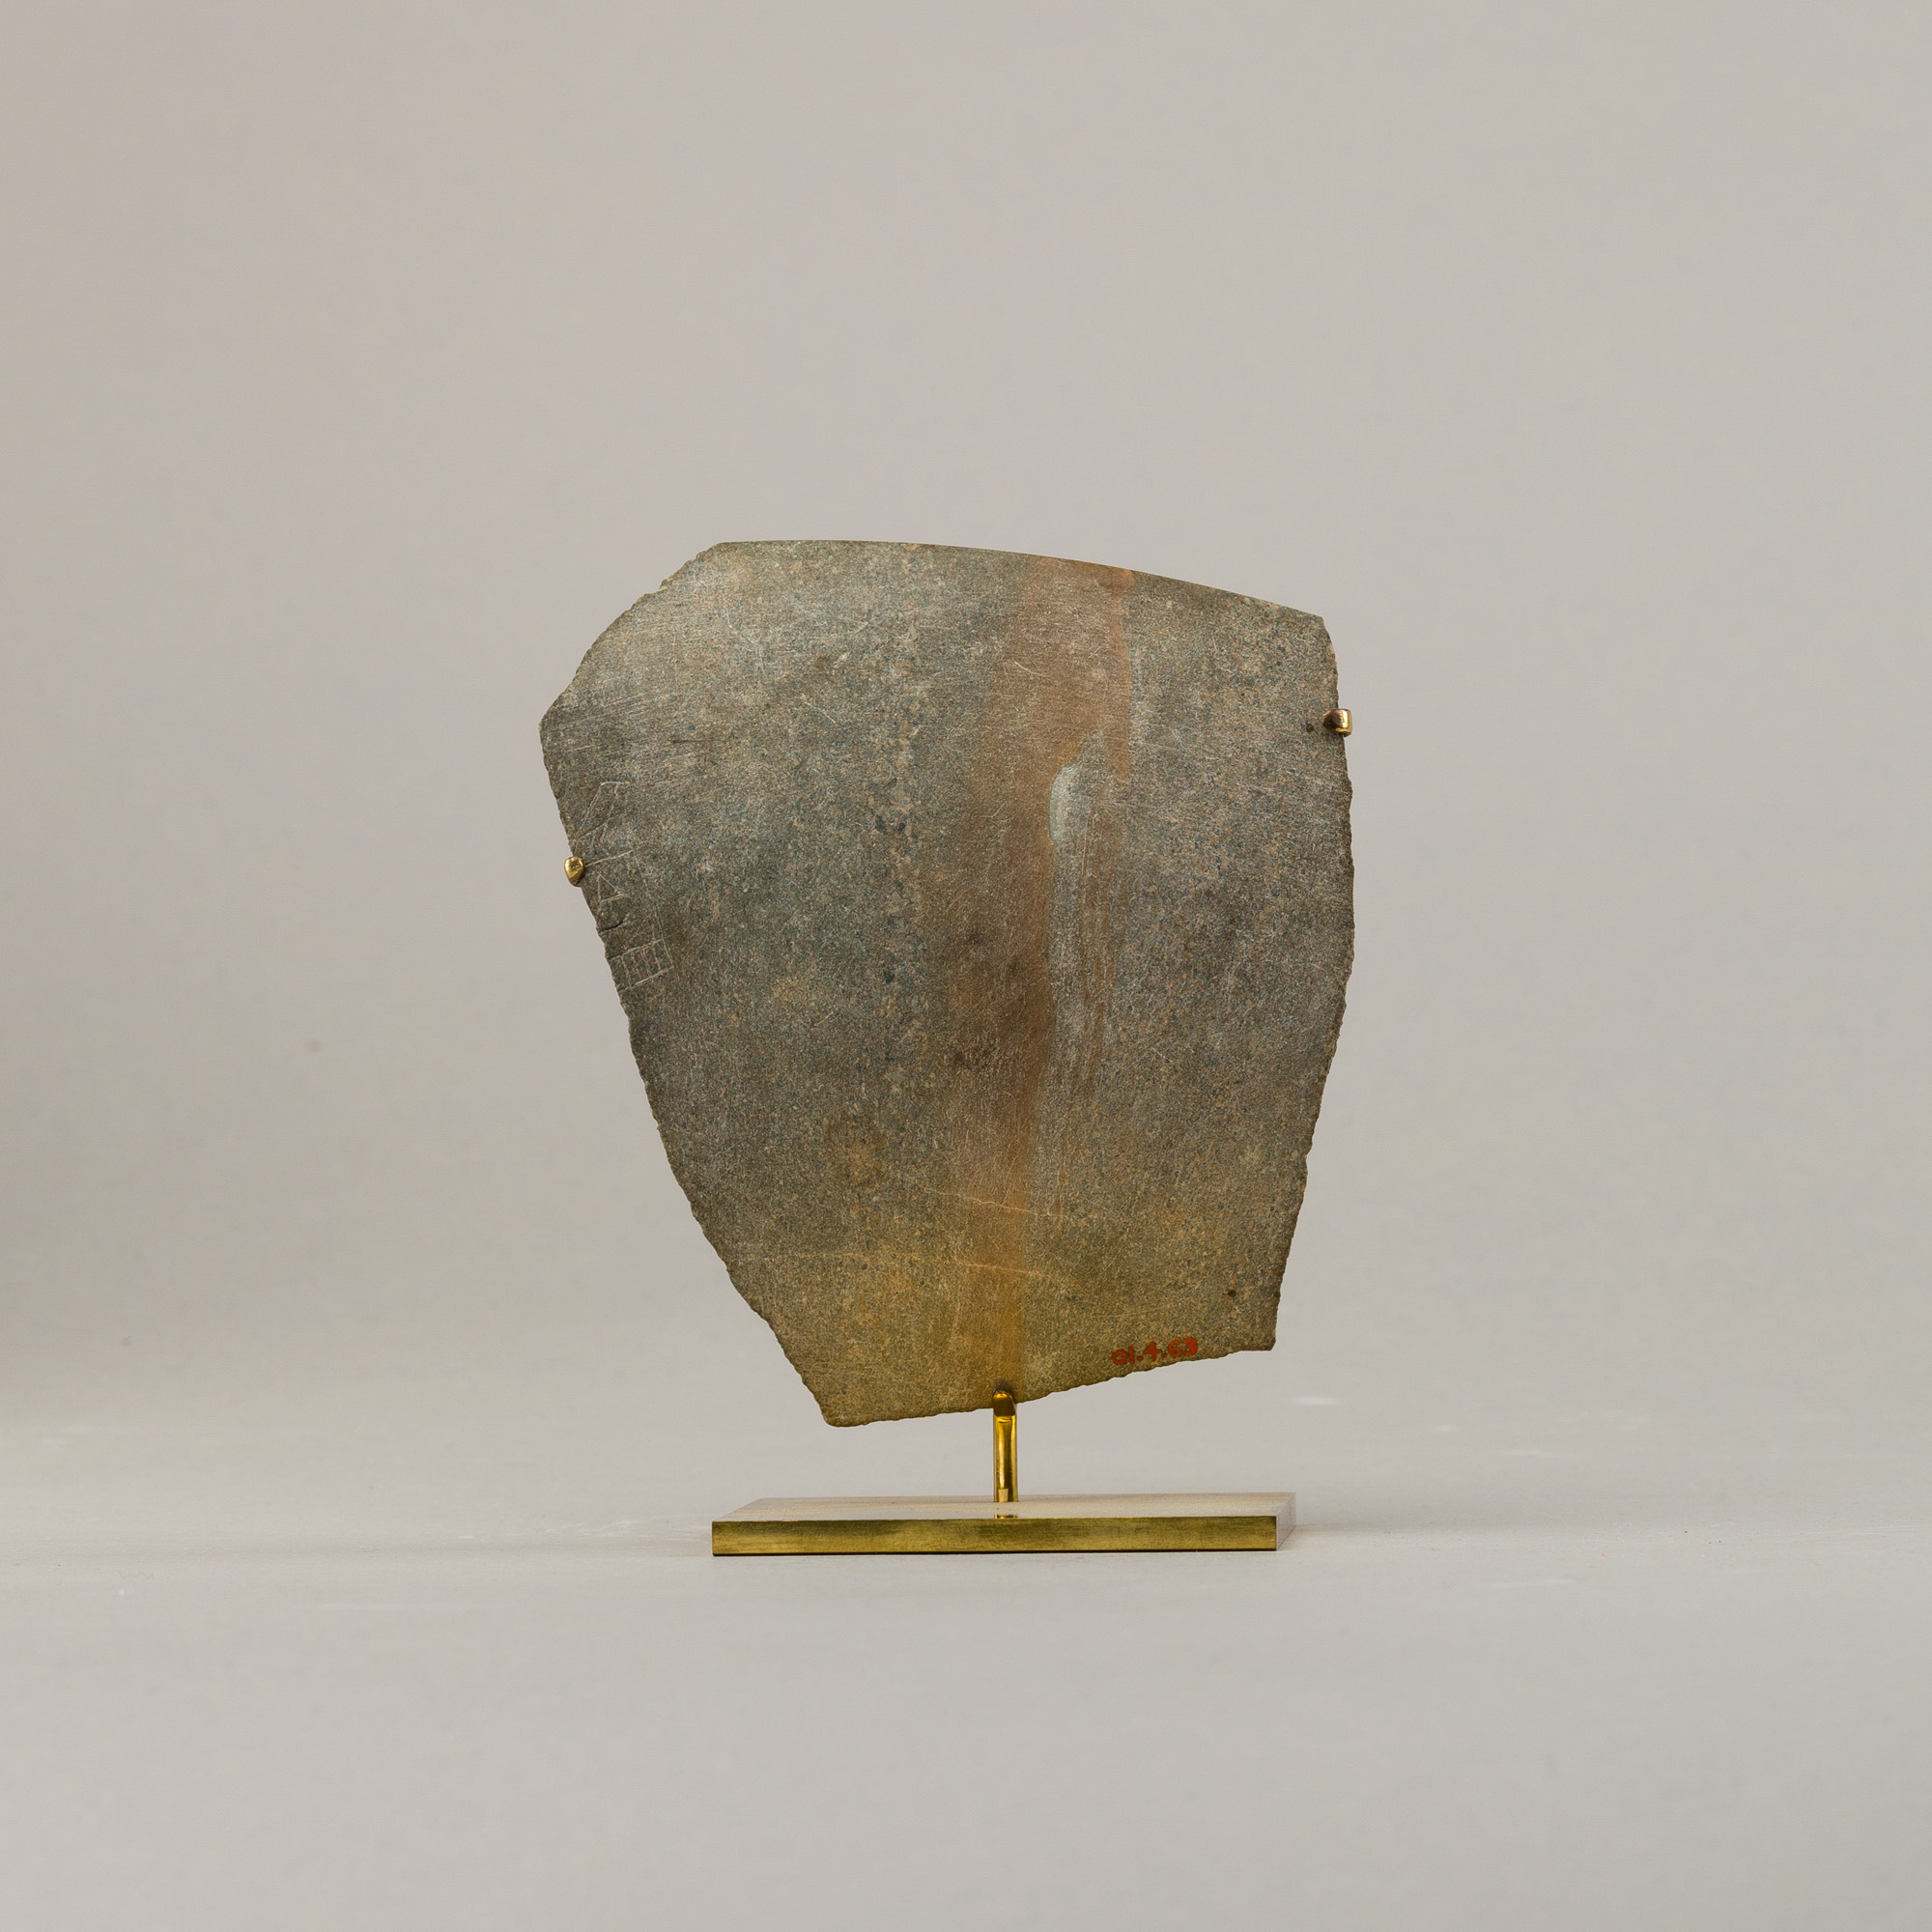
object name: vessel fragment, serekh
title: Sherd with a serekh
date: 3100-2649 BCE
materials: pottery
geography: egypt